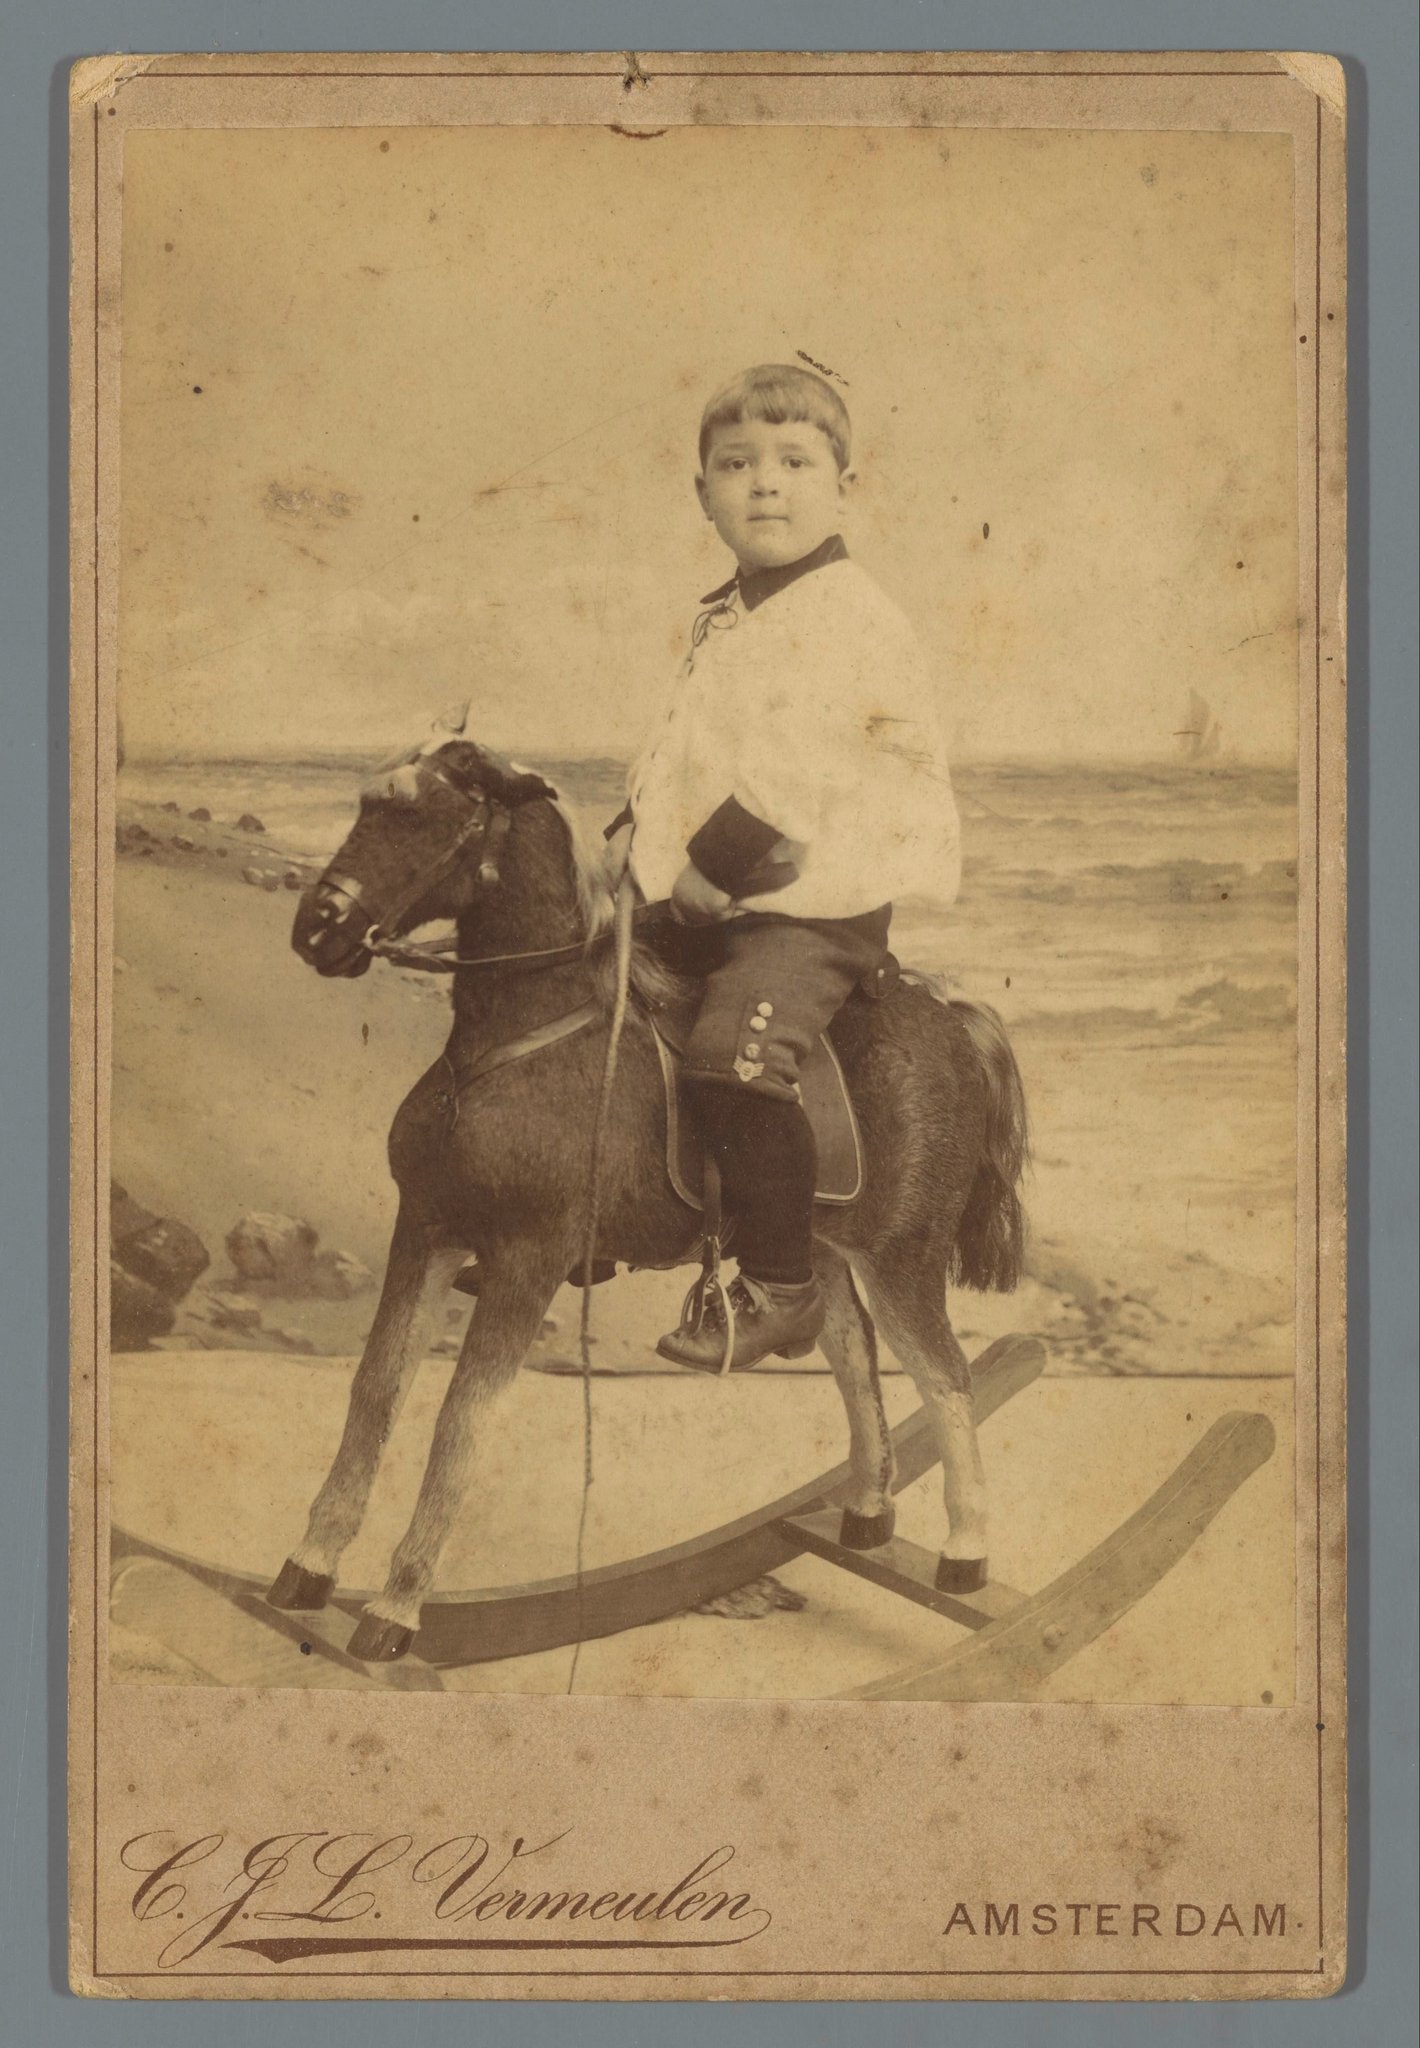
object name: cabinet photograph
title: Portret van een onbekende jongen op een hobbelpaard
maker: cornelis johannes lodewicus vermeulen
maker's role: fotograaf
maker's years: 1861-1936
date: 1888-1896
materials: cardboard, photographic support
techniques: albumen print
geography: amsterdam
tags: boy (child between toddler and youth), rocking-horse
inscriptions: name: ‘Photographische Ateliers C.J.L. Vermeulen Heerenstraat 6, Heiligenweg hoek Singel. Amsterdam. Specialiteit in vergrootingen.’